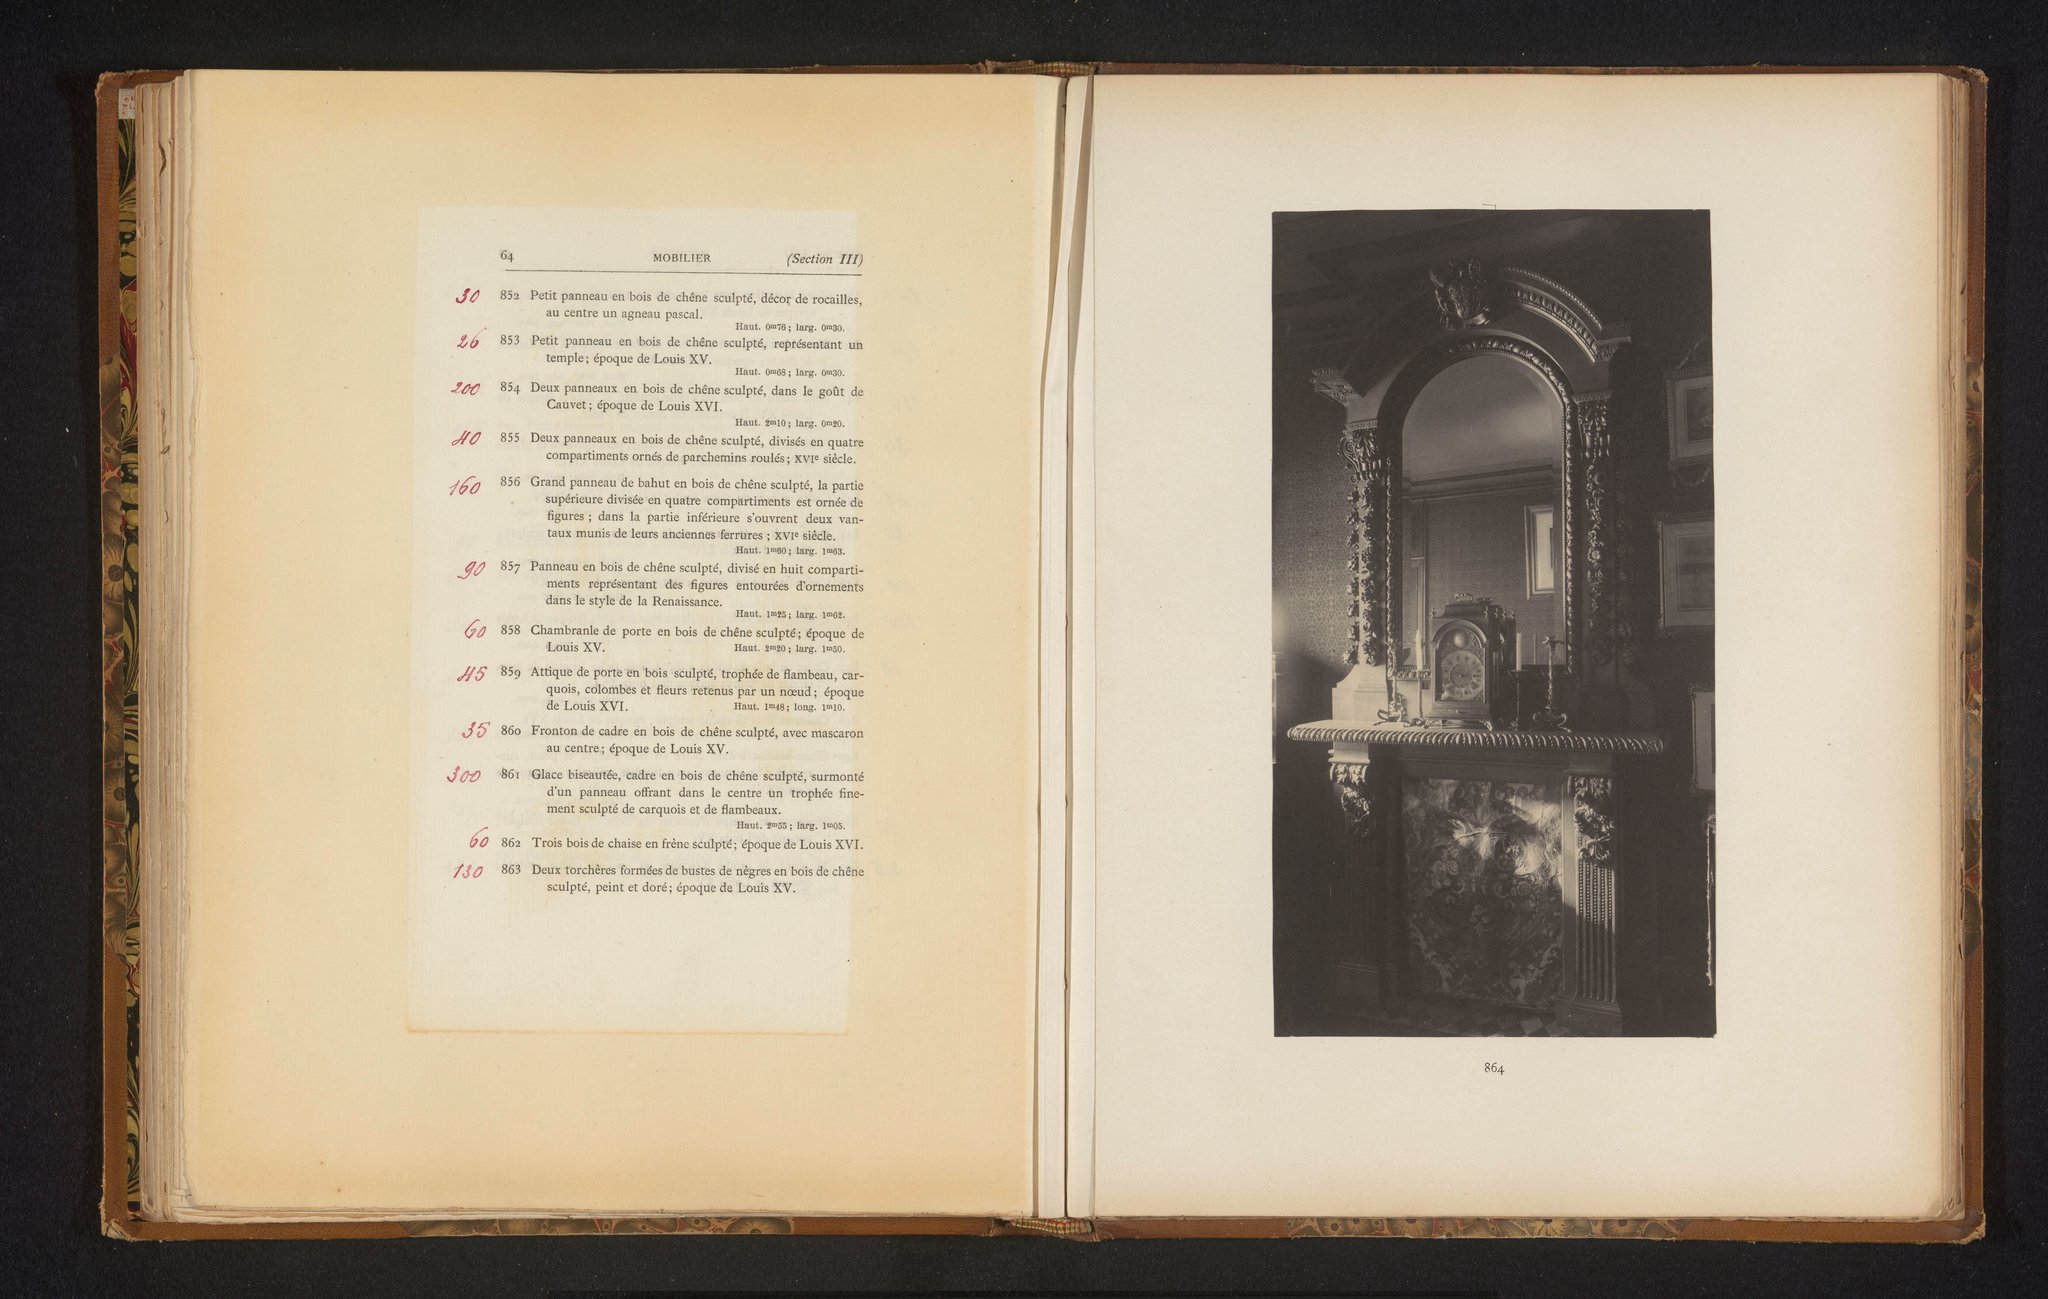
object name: page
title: Schoorsteen met klok in het huis van Antonin Terme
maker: Anonymous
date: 1880-1885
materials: photographic support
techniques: platinum process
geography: liège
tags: art collection, art gallery, clock, chimney-piece, mantelpiece